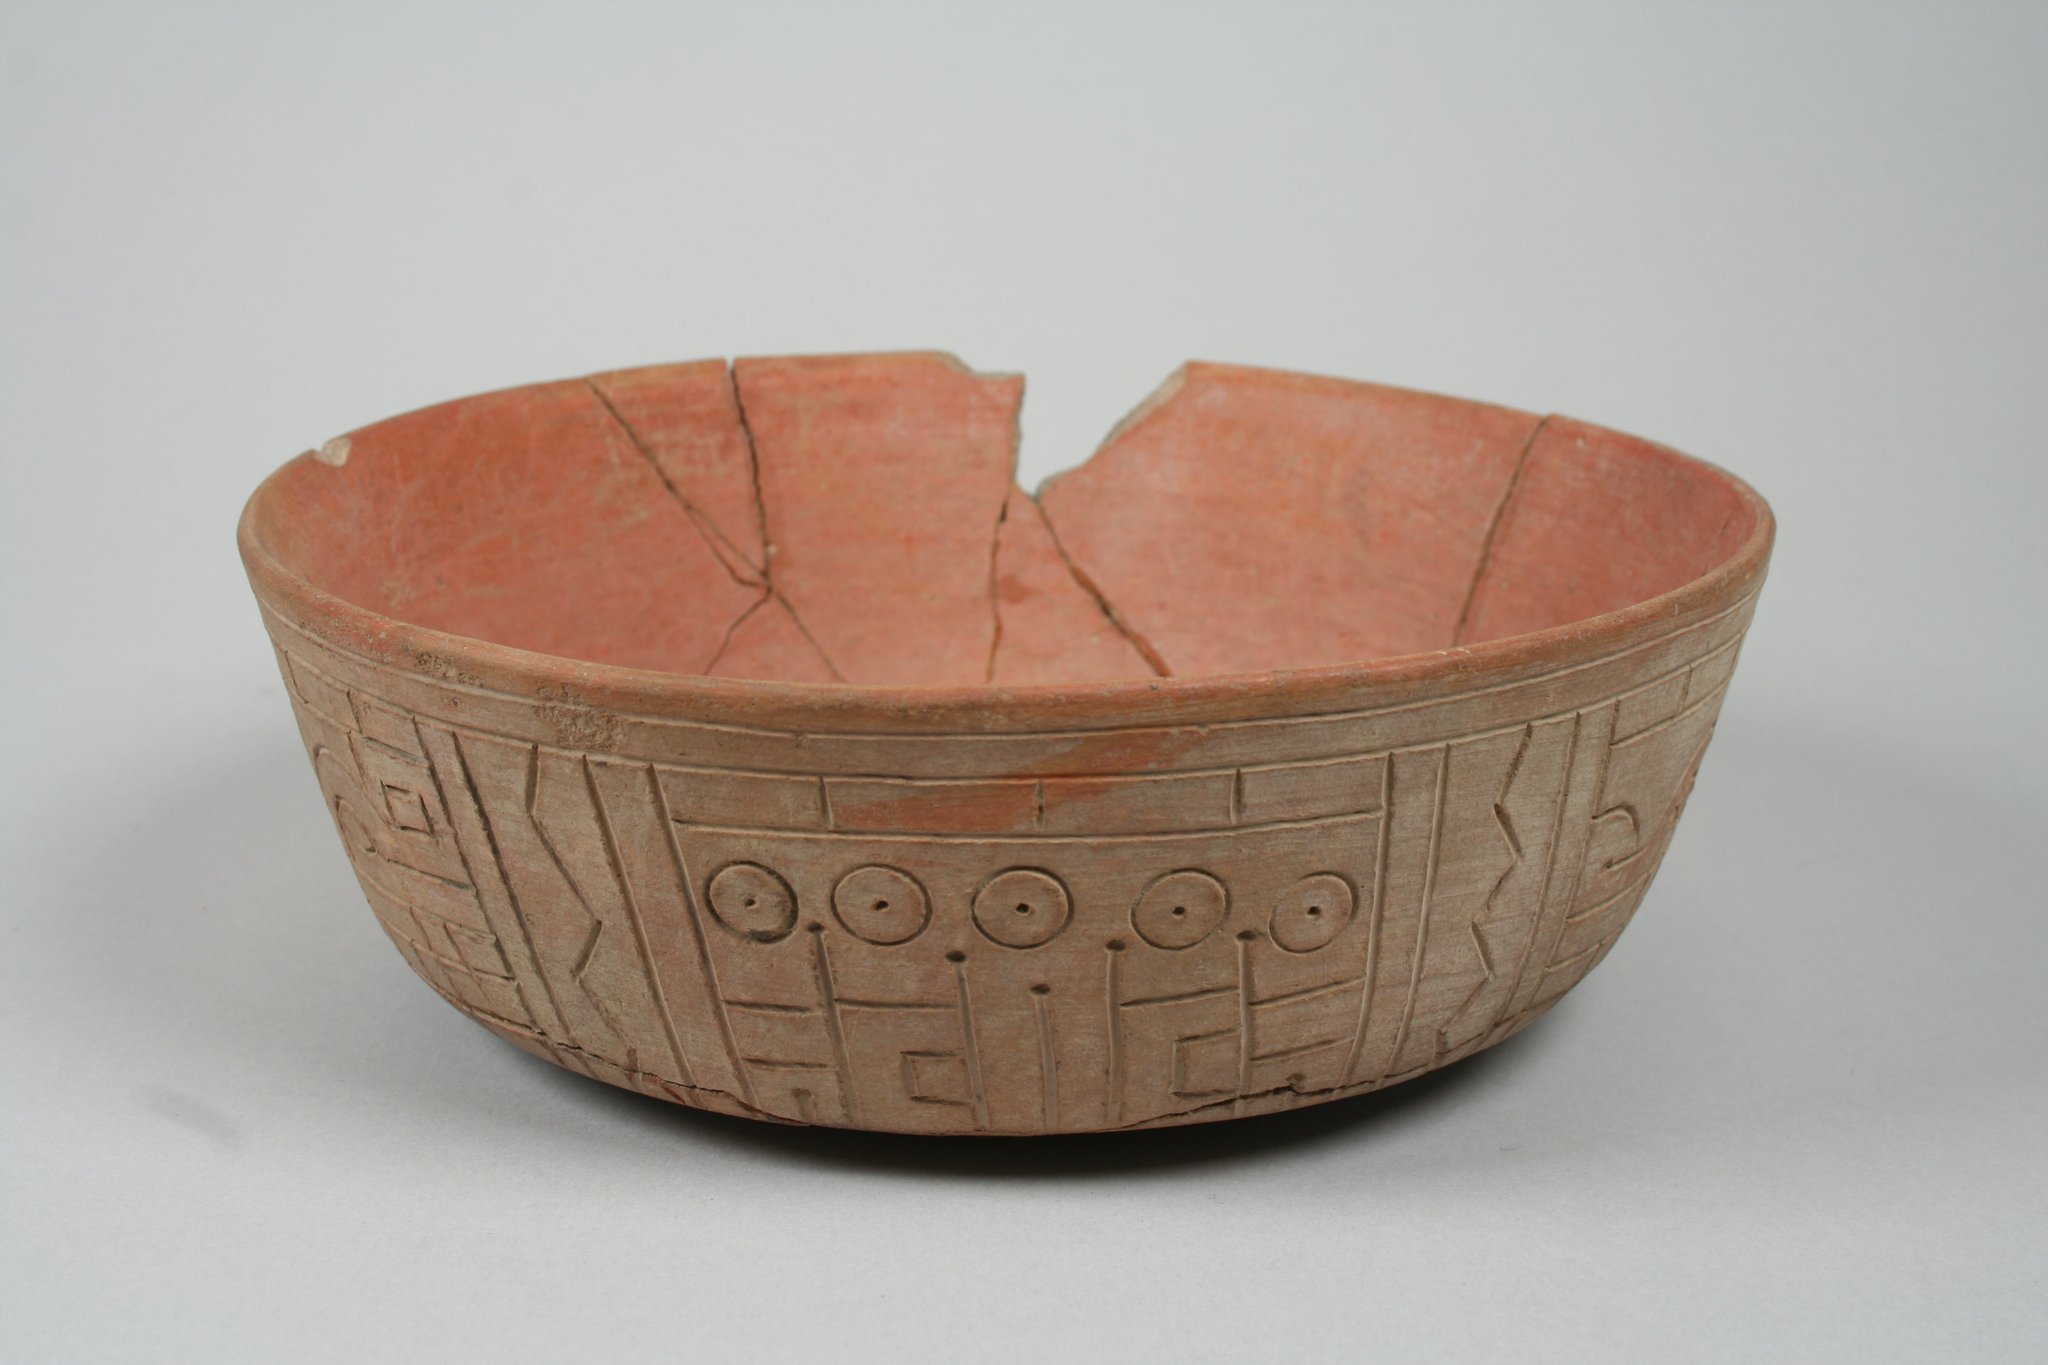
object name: bowl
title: Incised bowl with fox motif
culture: paracas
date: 700-401 BCE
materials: ceramic, pigment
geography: peru